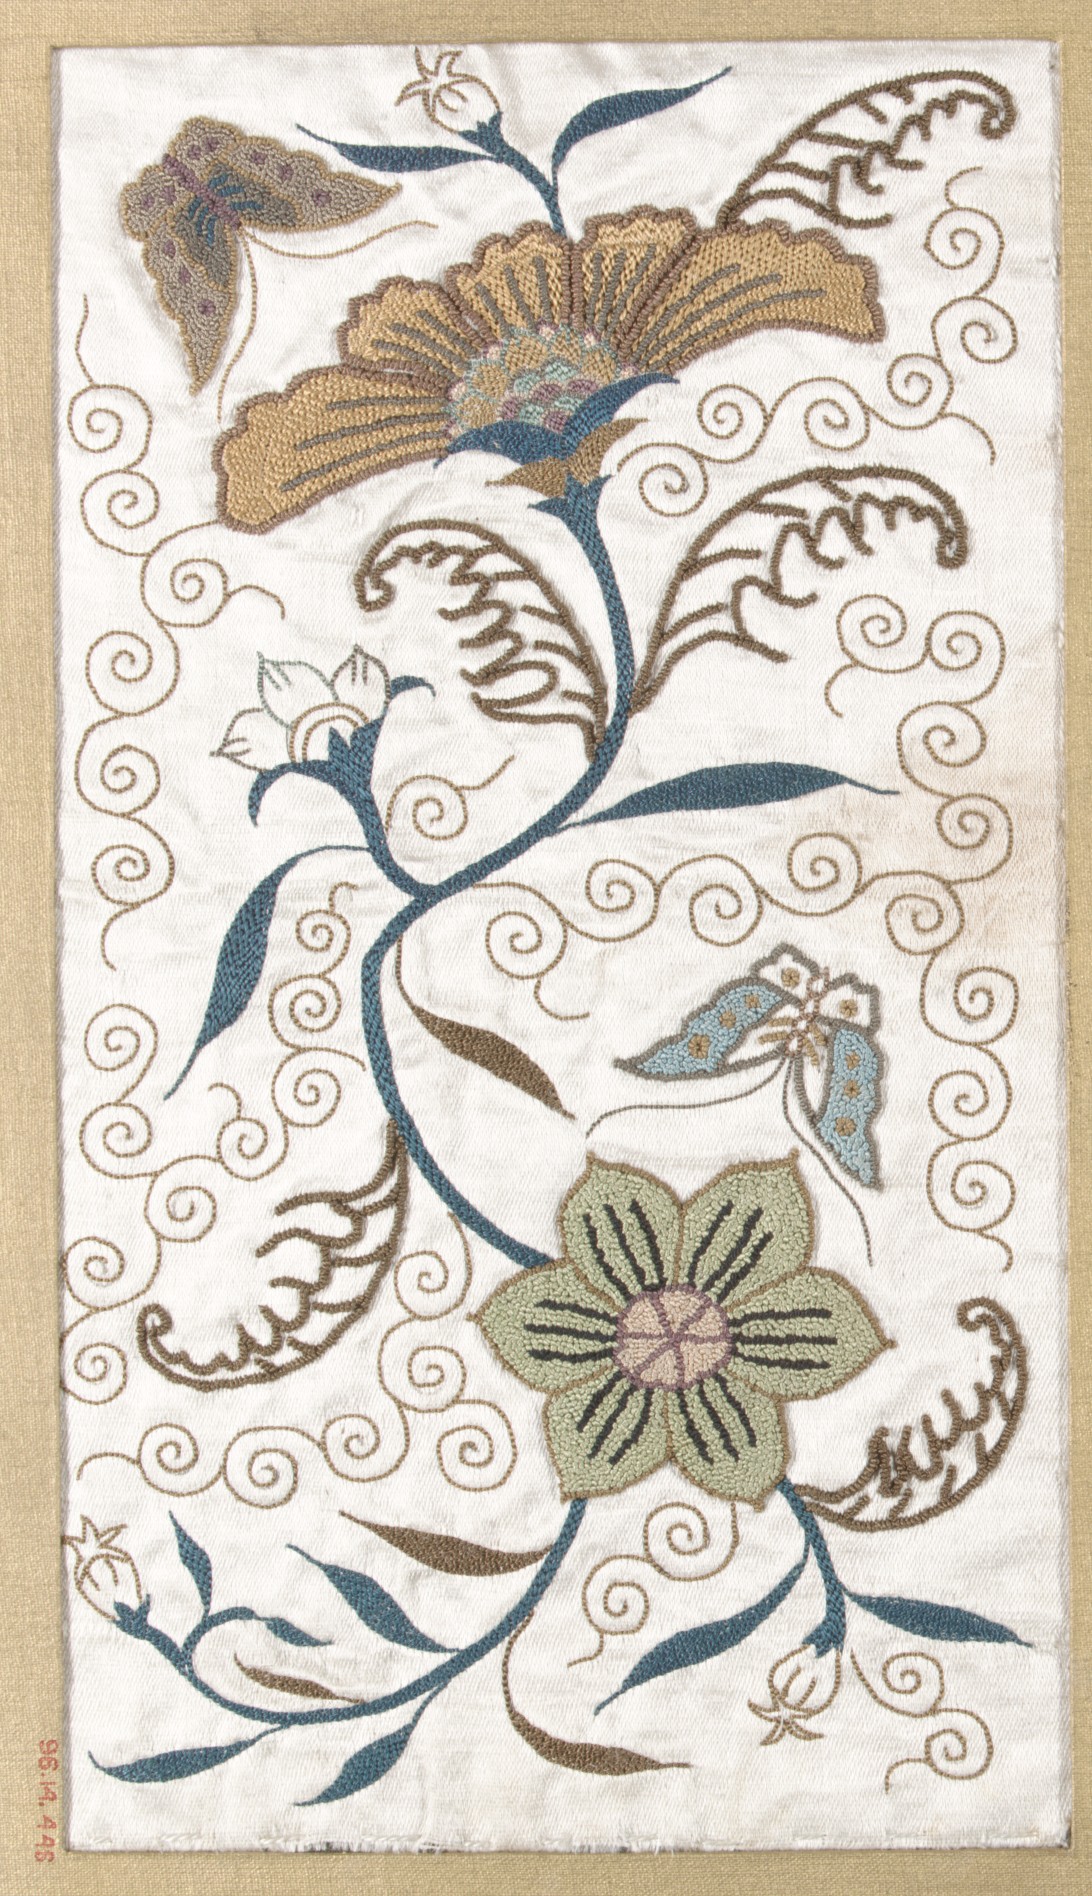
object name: piece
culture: japanese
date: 1701-1900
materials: silk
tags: butterflies